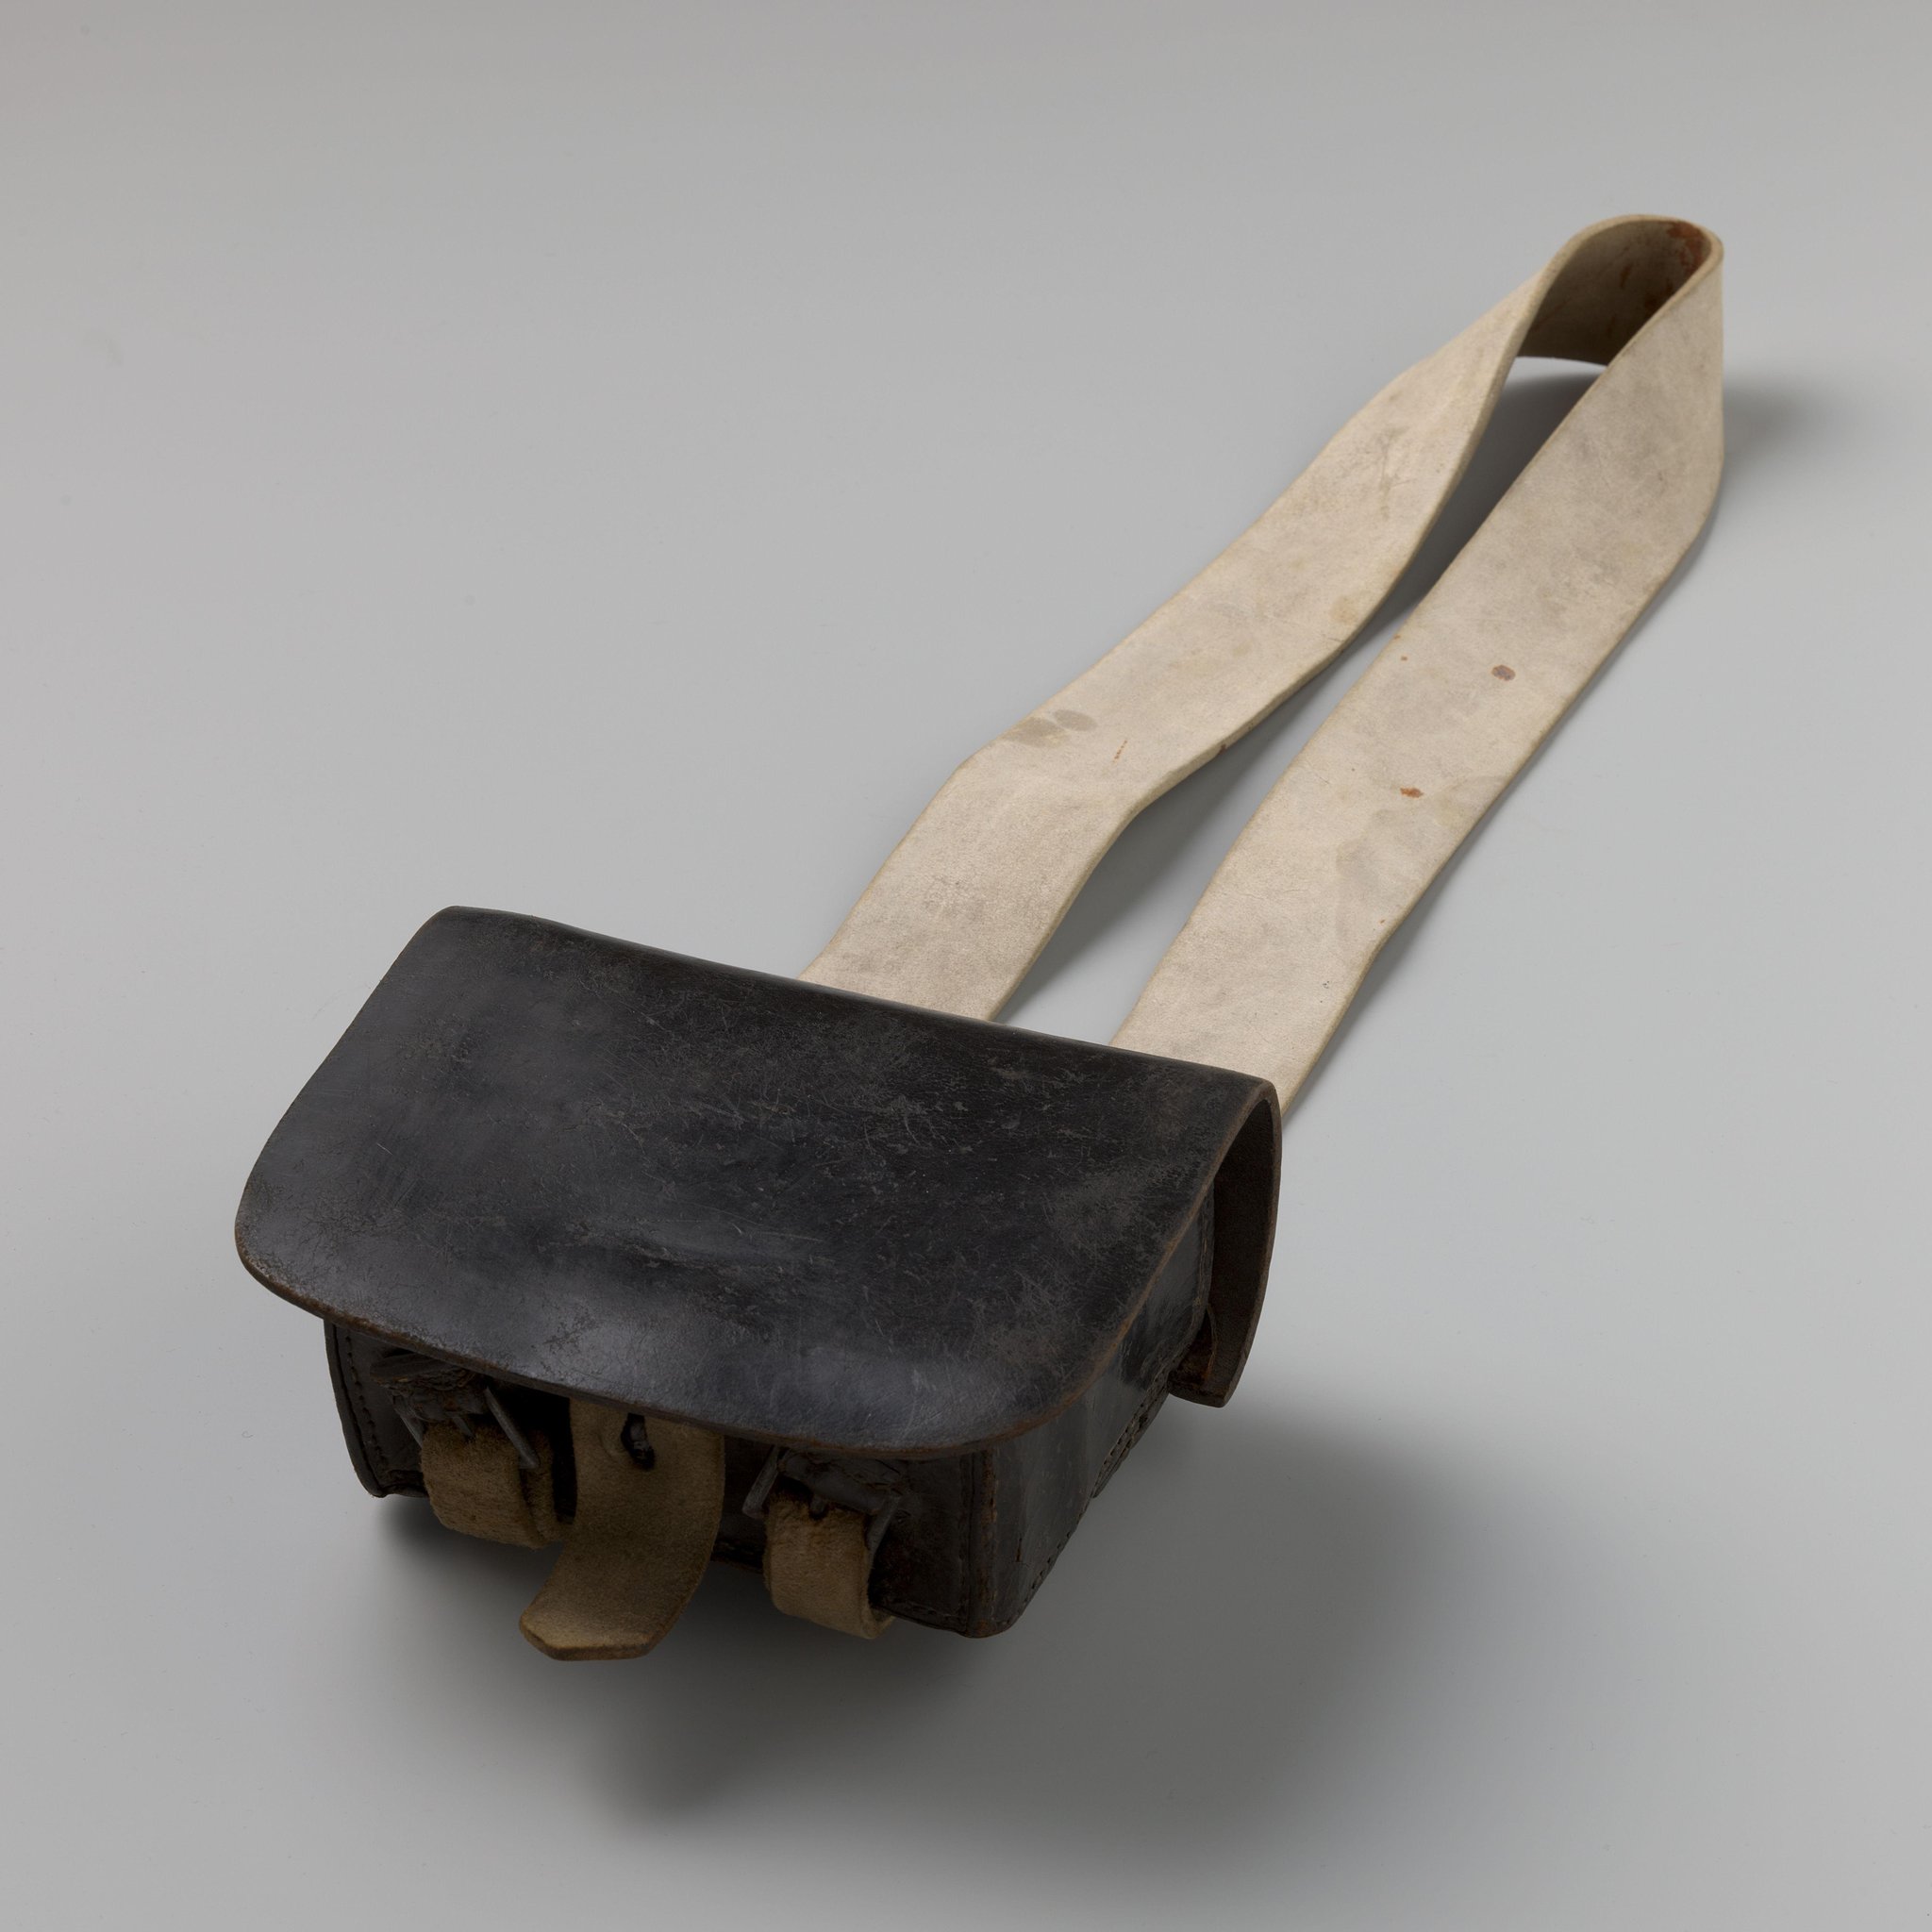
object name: cartridge pouch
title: Patroontas aan witte draagriem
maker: Anonymous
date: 1825-1830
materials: iron, leather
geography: netherlands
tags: netherlands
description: Zwart gelakte leren patroontas met witte bandelier. De tas is rechthoekig, van ijzer en verdeeld in diverse vakken en bekleed met leer. De naturel leren riem is aan éen zijde gewit met pijpaarde. Zie NG-NM-10385-156-1.